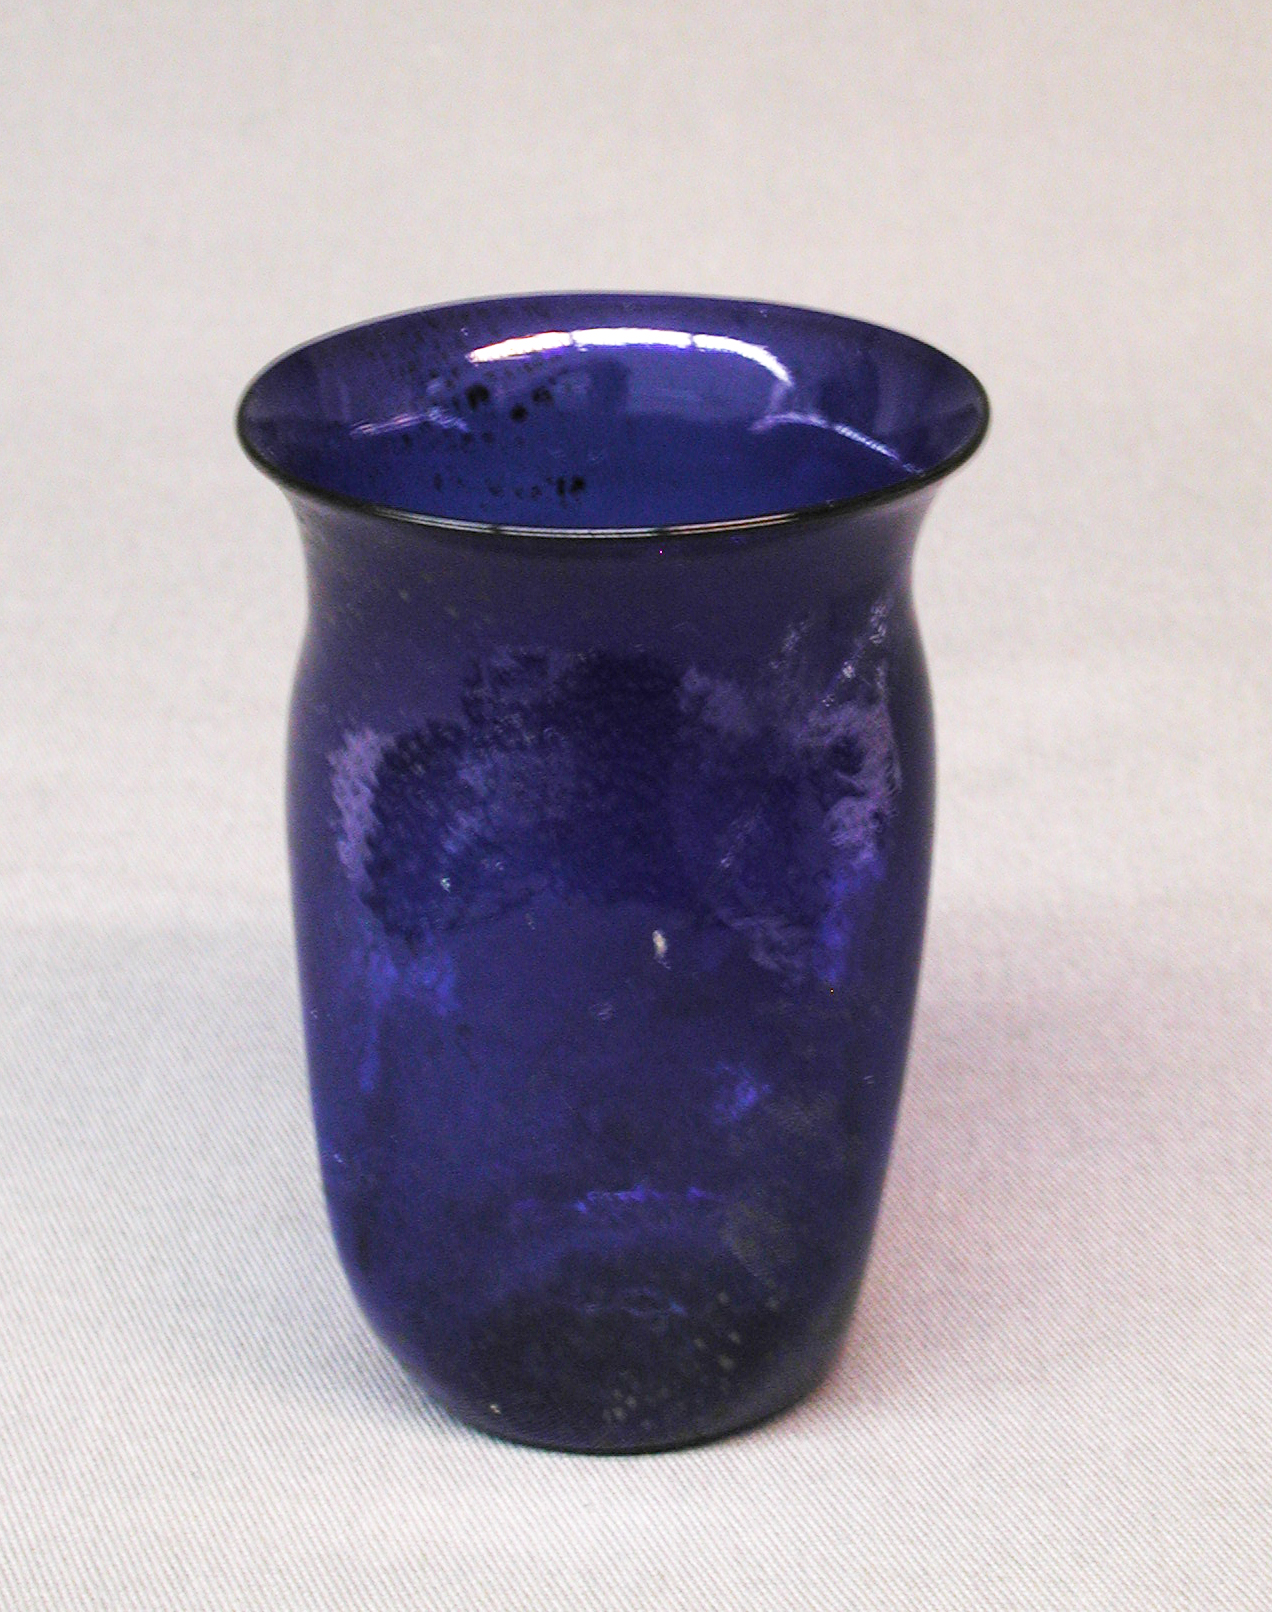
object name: jar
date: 1801-1900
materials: glass